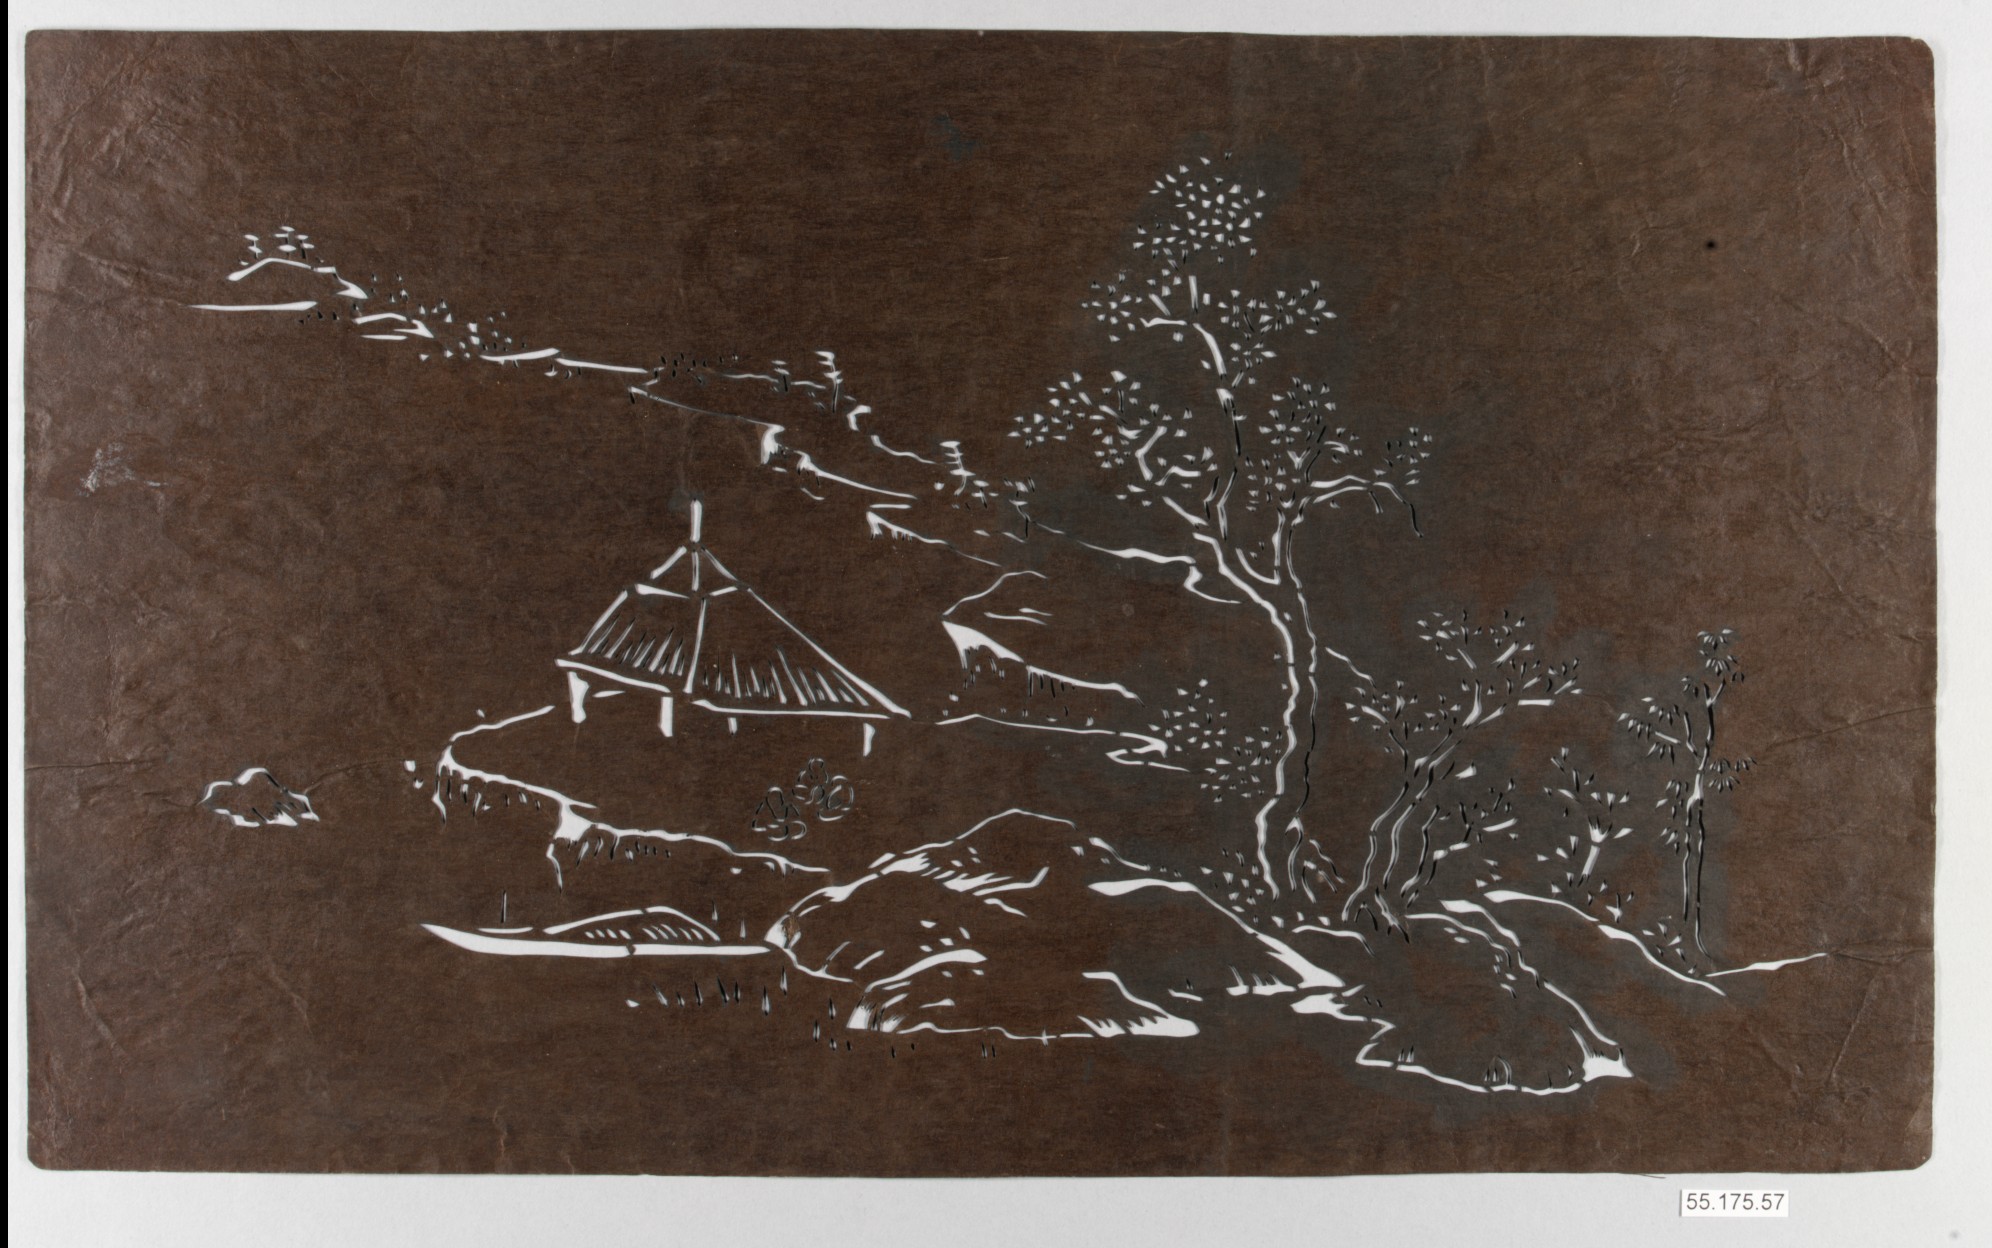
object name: stencil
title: Stencil with Pattern of Landscape with Boat, Hut, and Figures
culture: japanese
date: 1801-1900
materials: paper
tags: landscapes